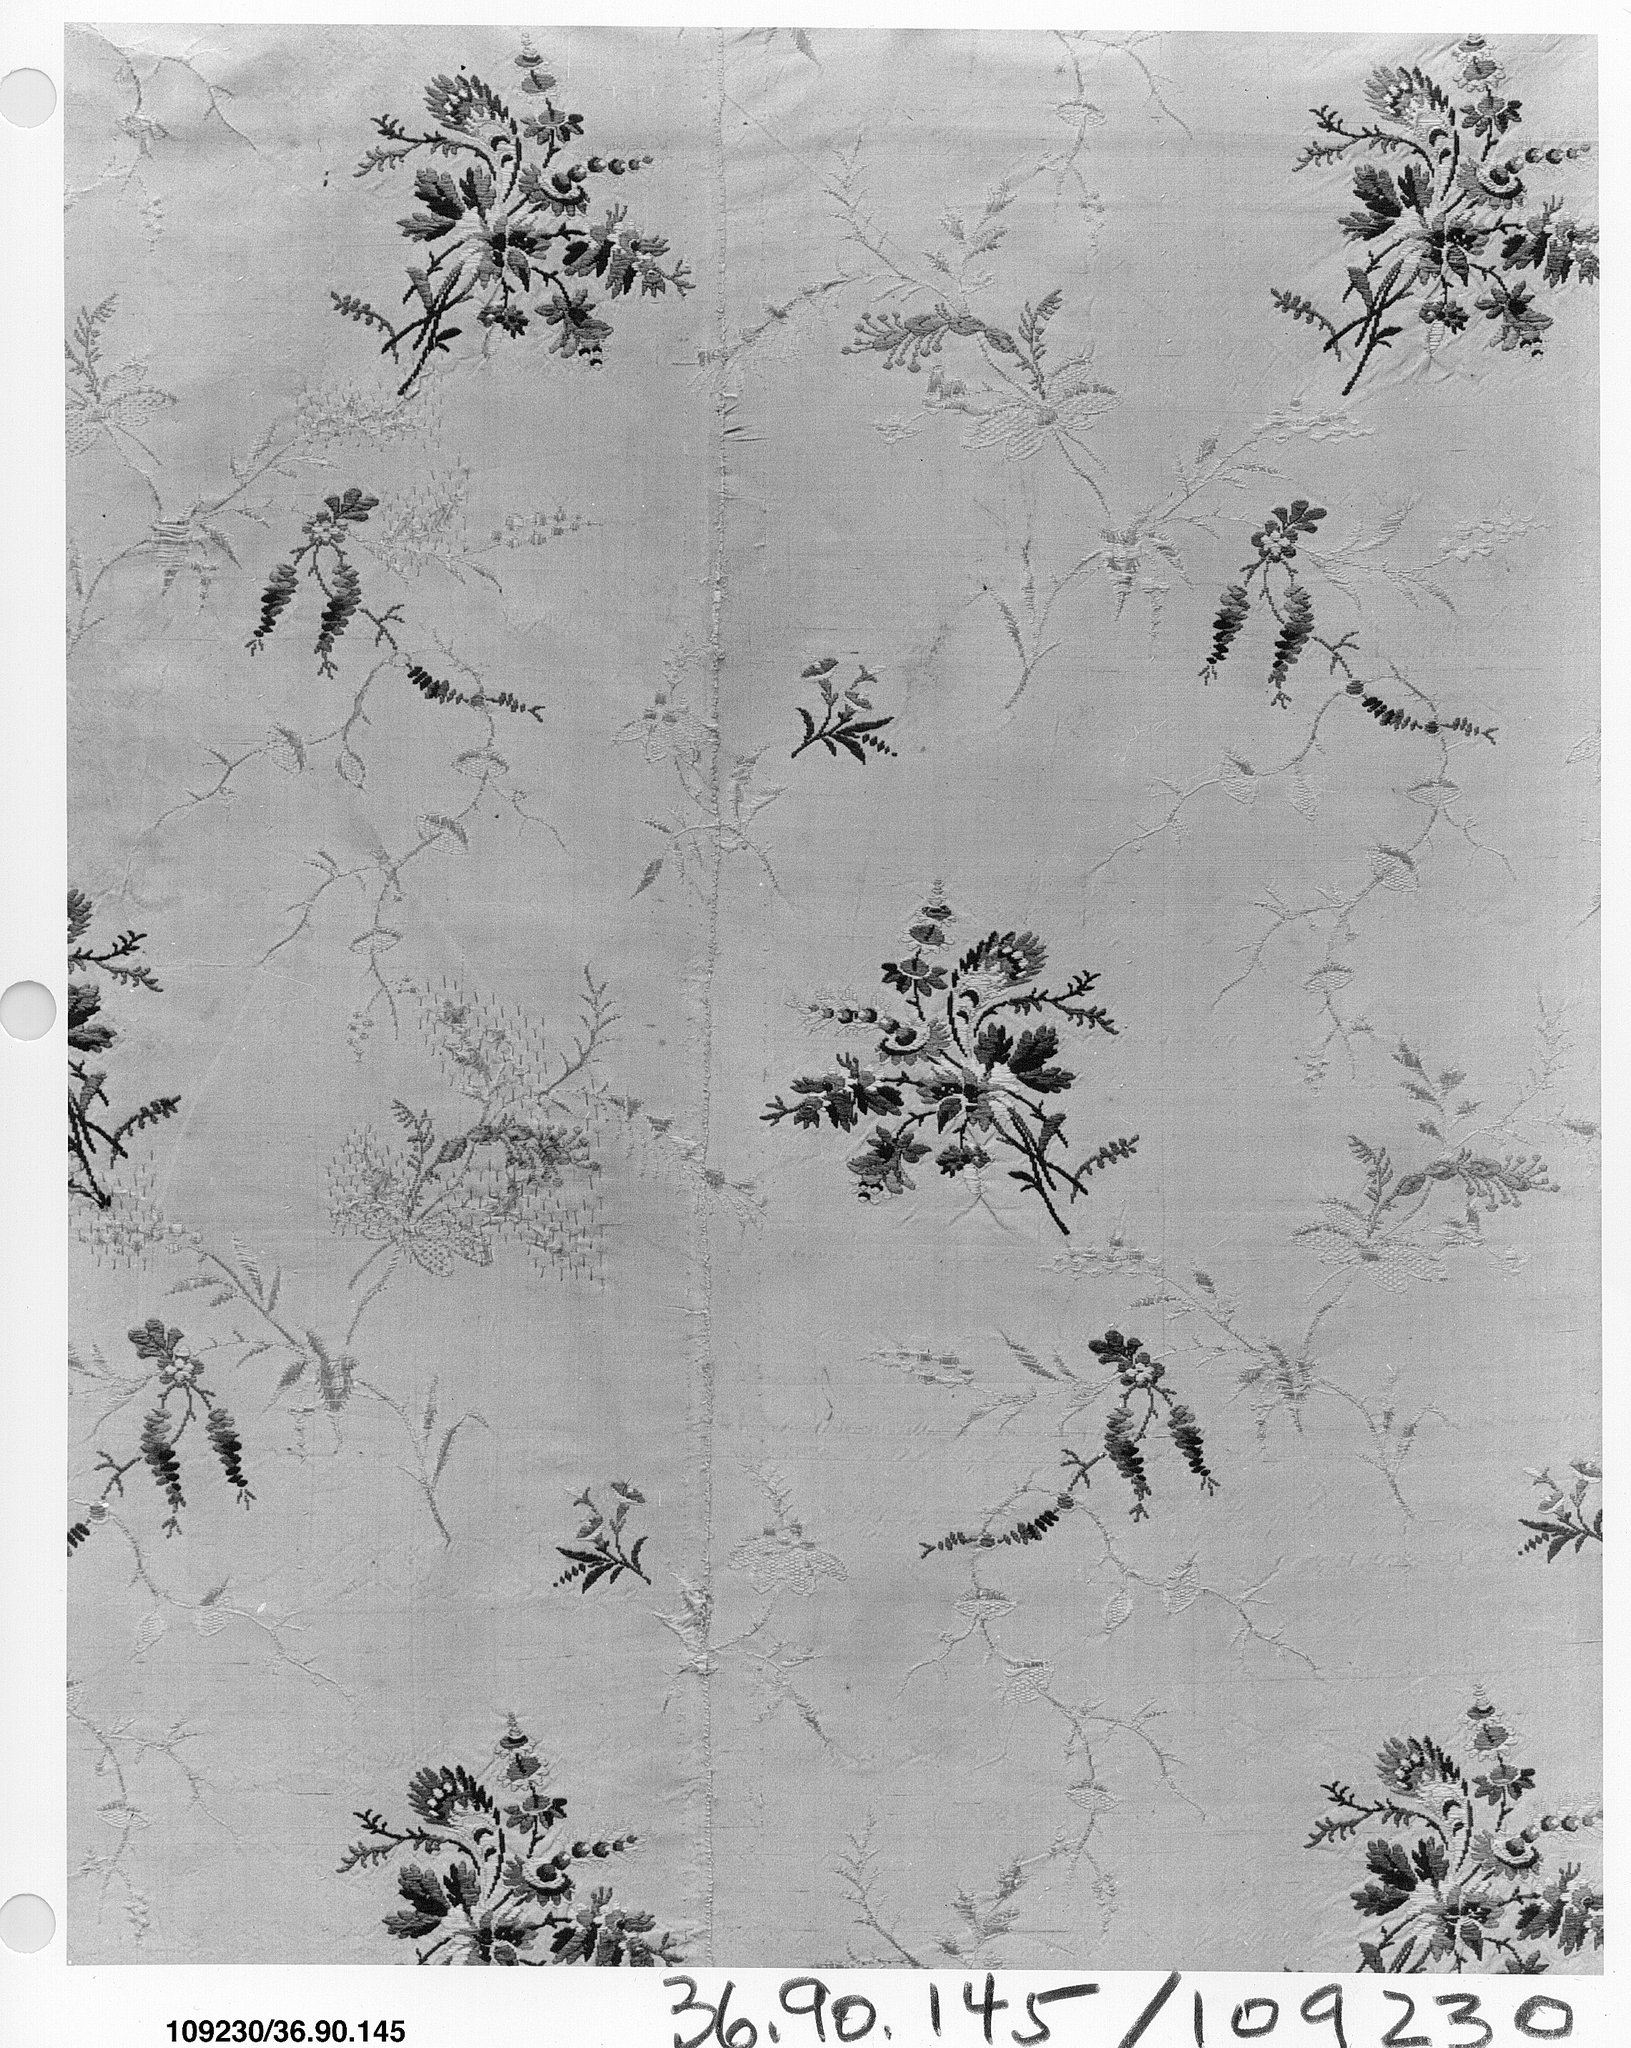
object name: piece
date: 1760-1770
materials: silk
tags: leaves